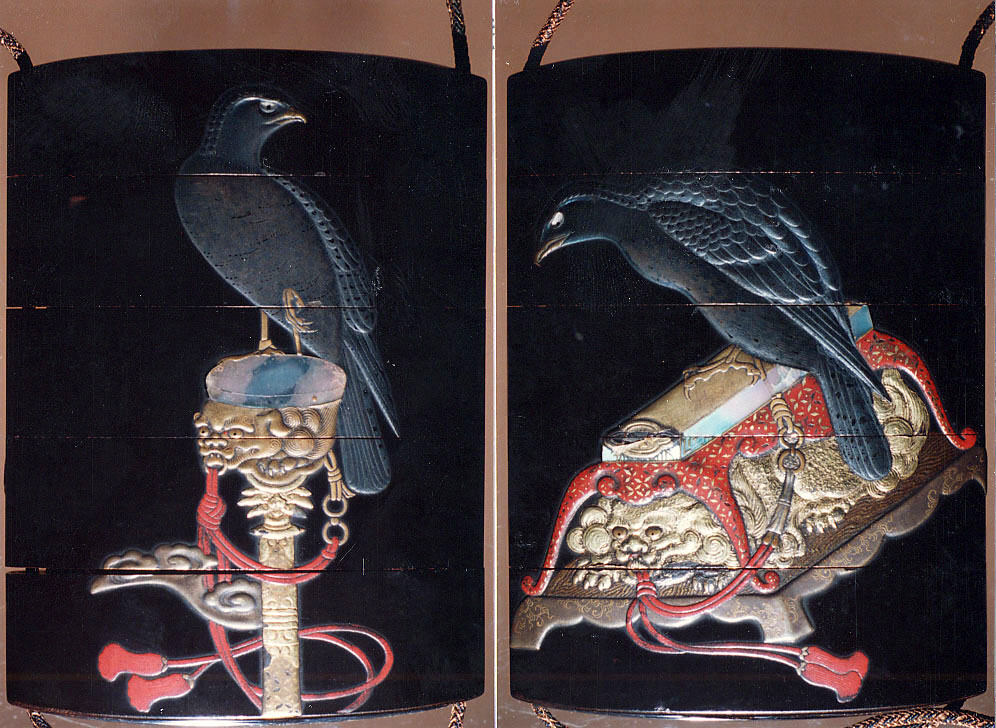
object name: inrō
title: Case (Inrō) with Design of Hawk on Tasseled Perch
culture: japanese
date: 1801-1900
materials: gold, lacquer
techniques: fundame, hiramakie, inlay, roiro, maki-e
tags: hawks